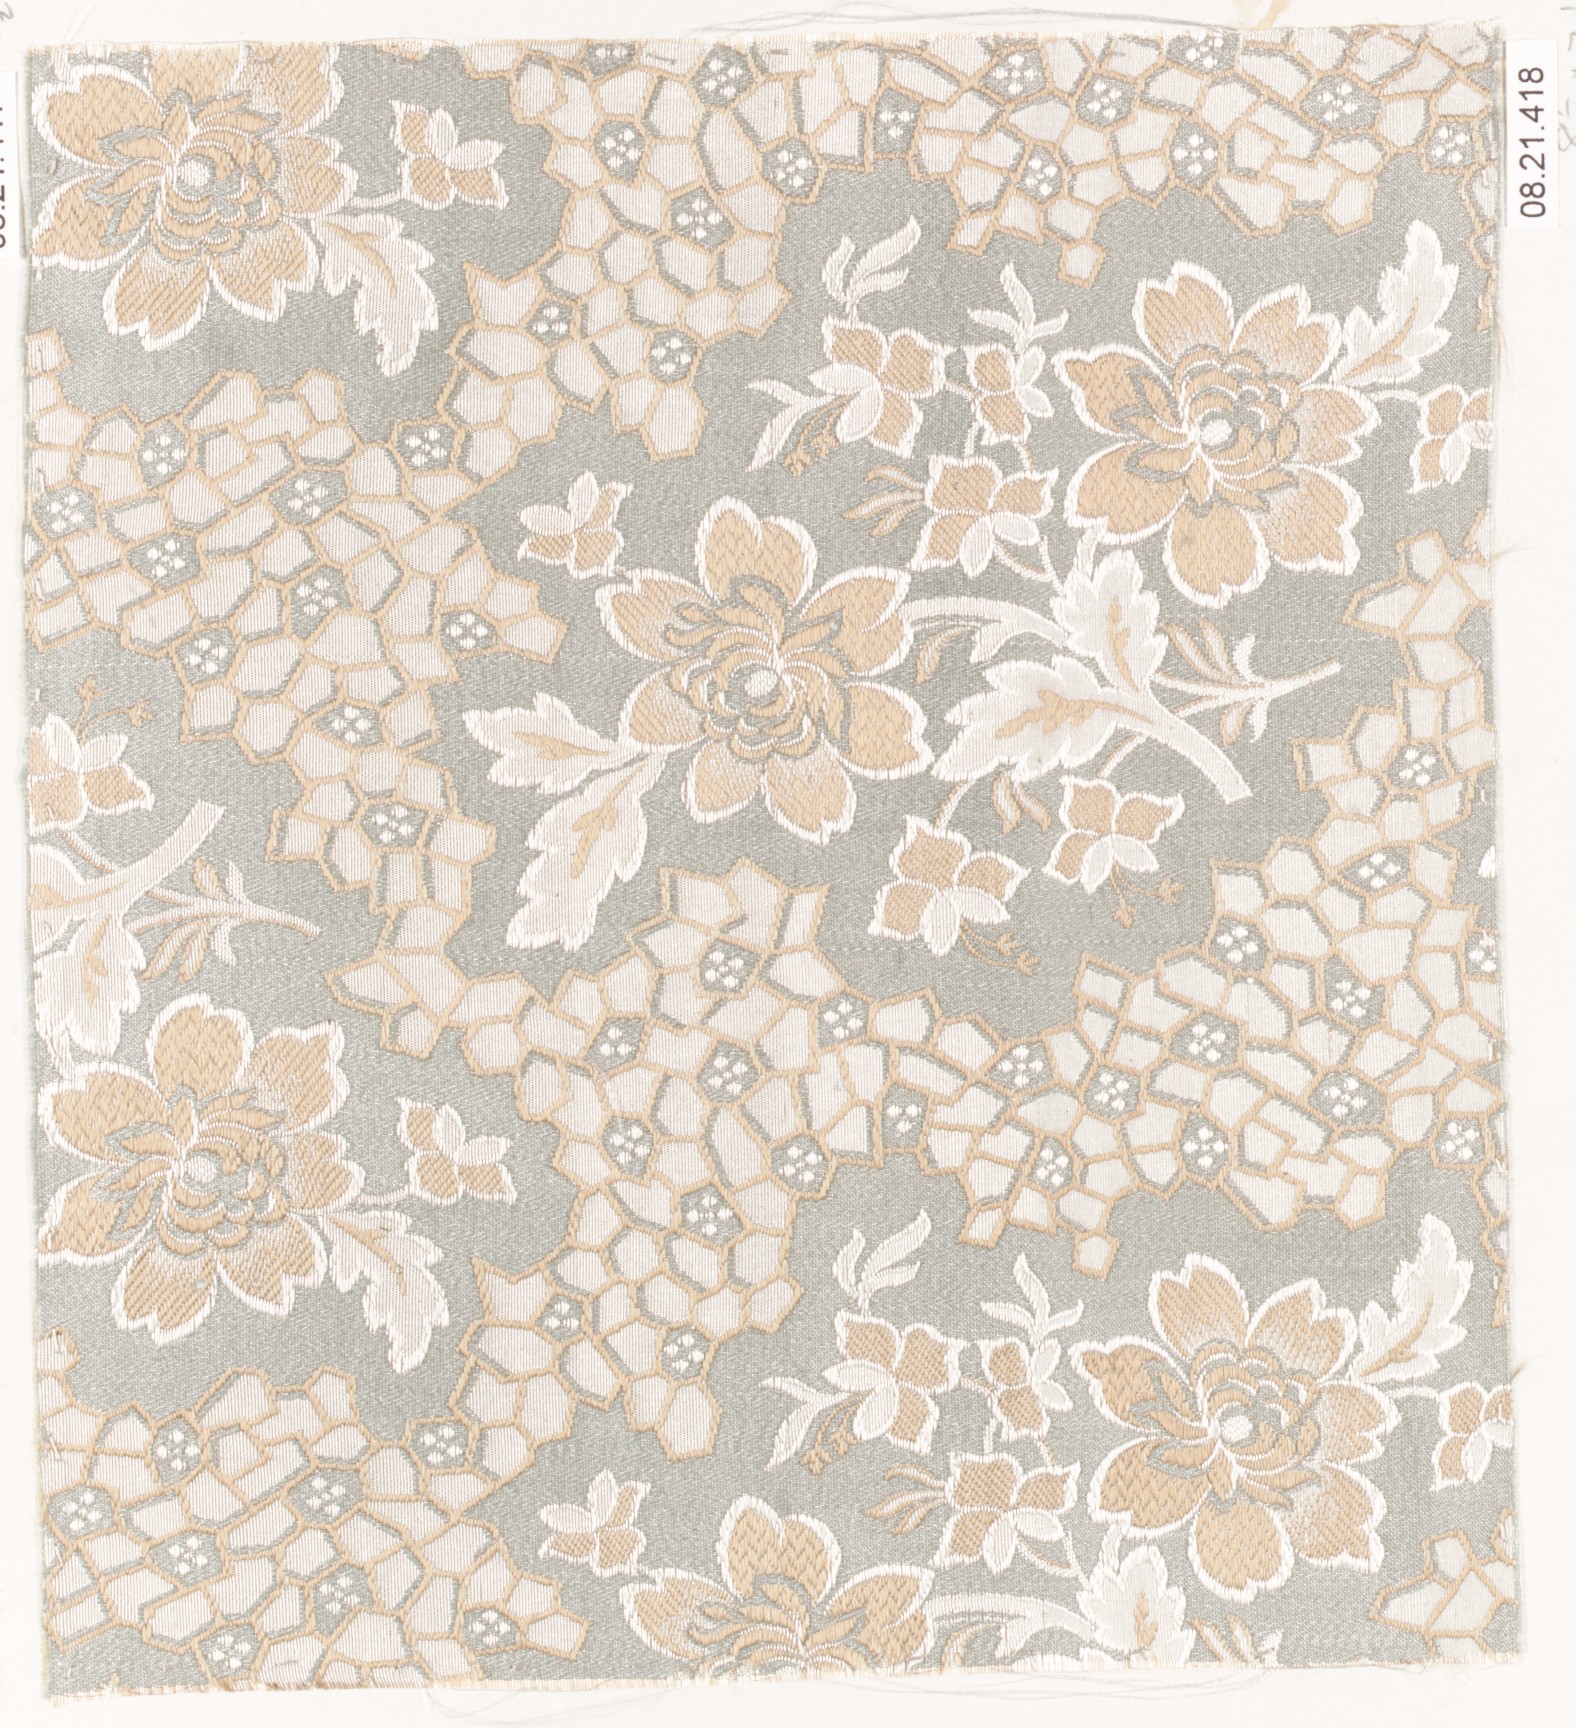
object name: textile sample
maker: Anonymous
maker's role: designer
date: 1900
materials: silk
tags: flowers